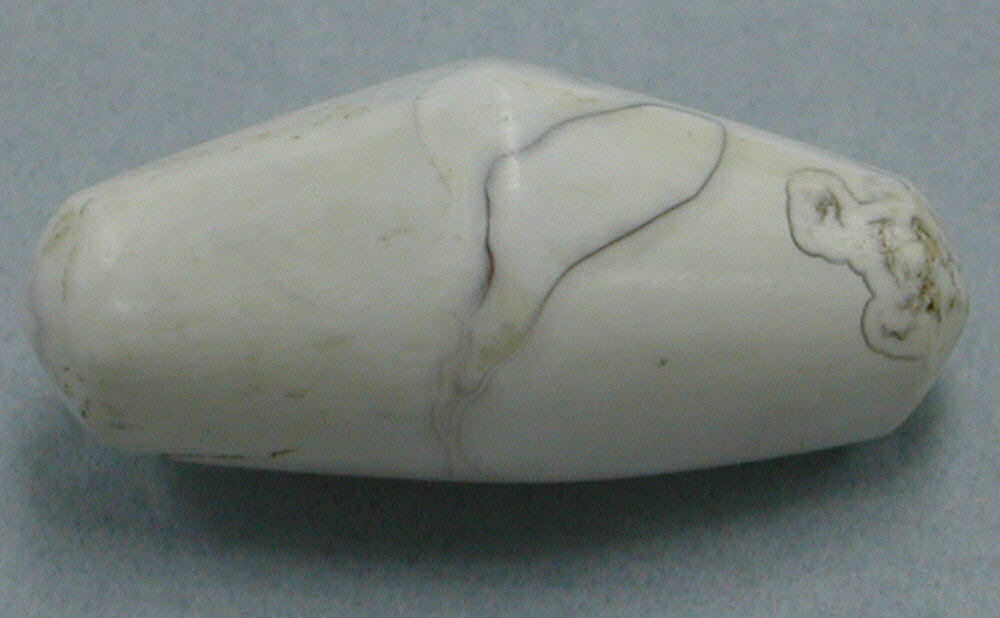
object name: ritual stone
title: Stone Pulidor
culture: mexican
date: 1501-1600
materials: stone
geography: mexico